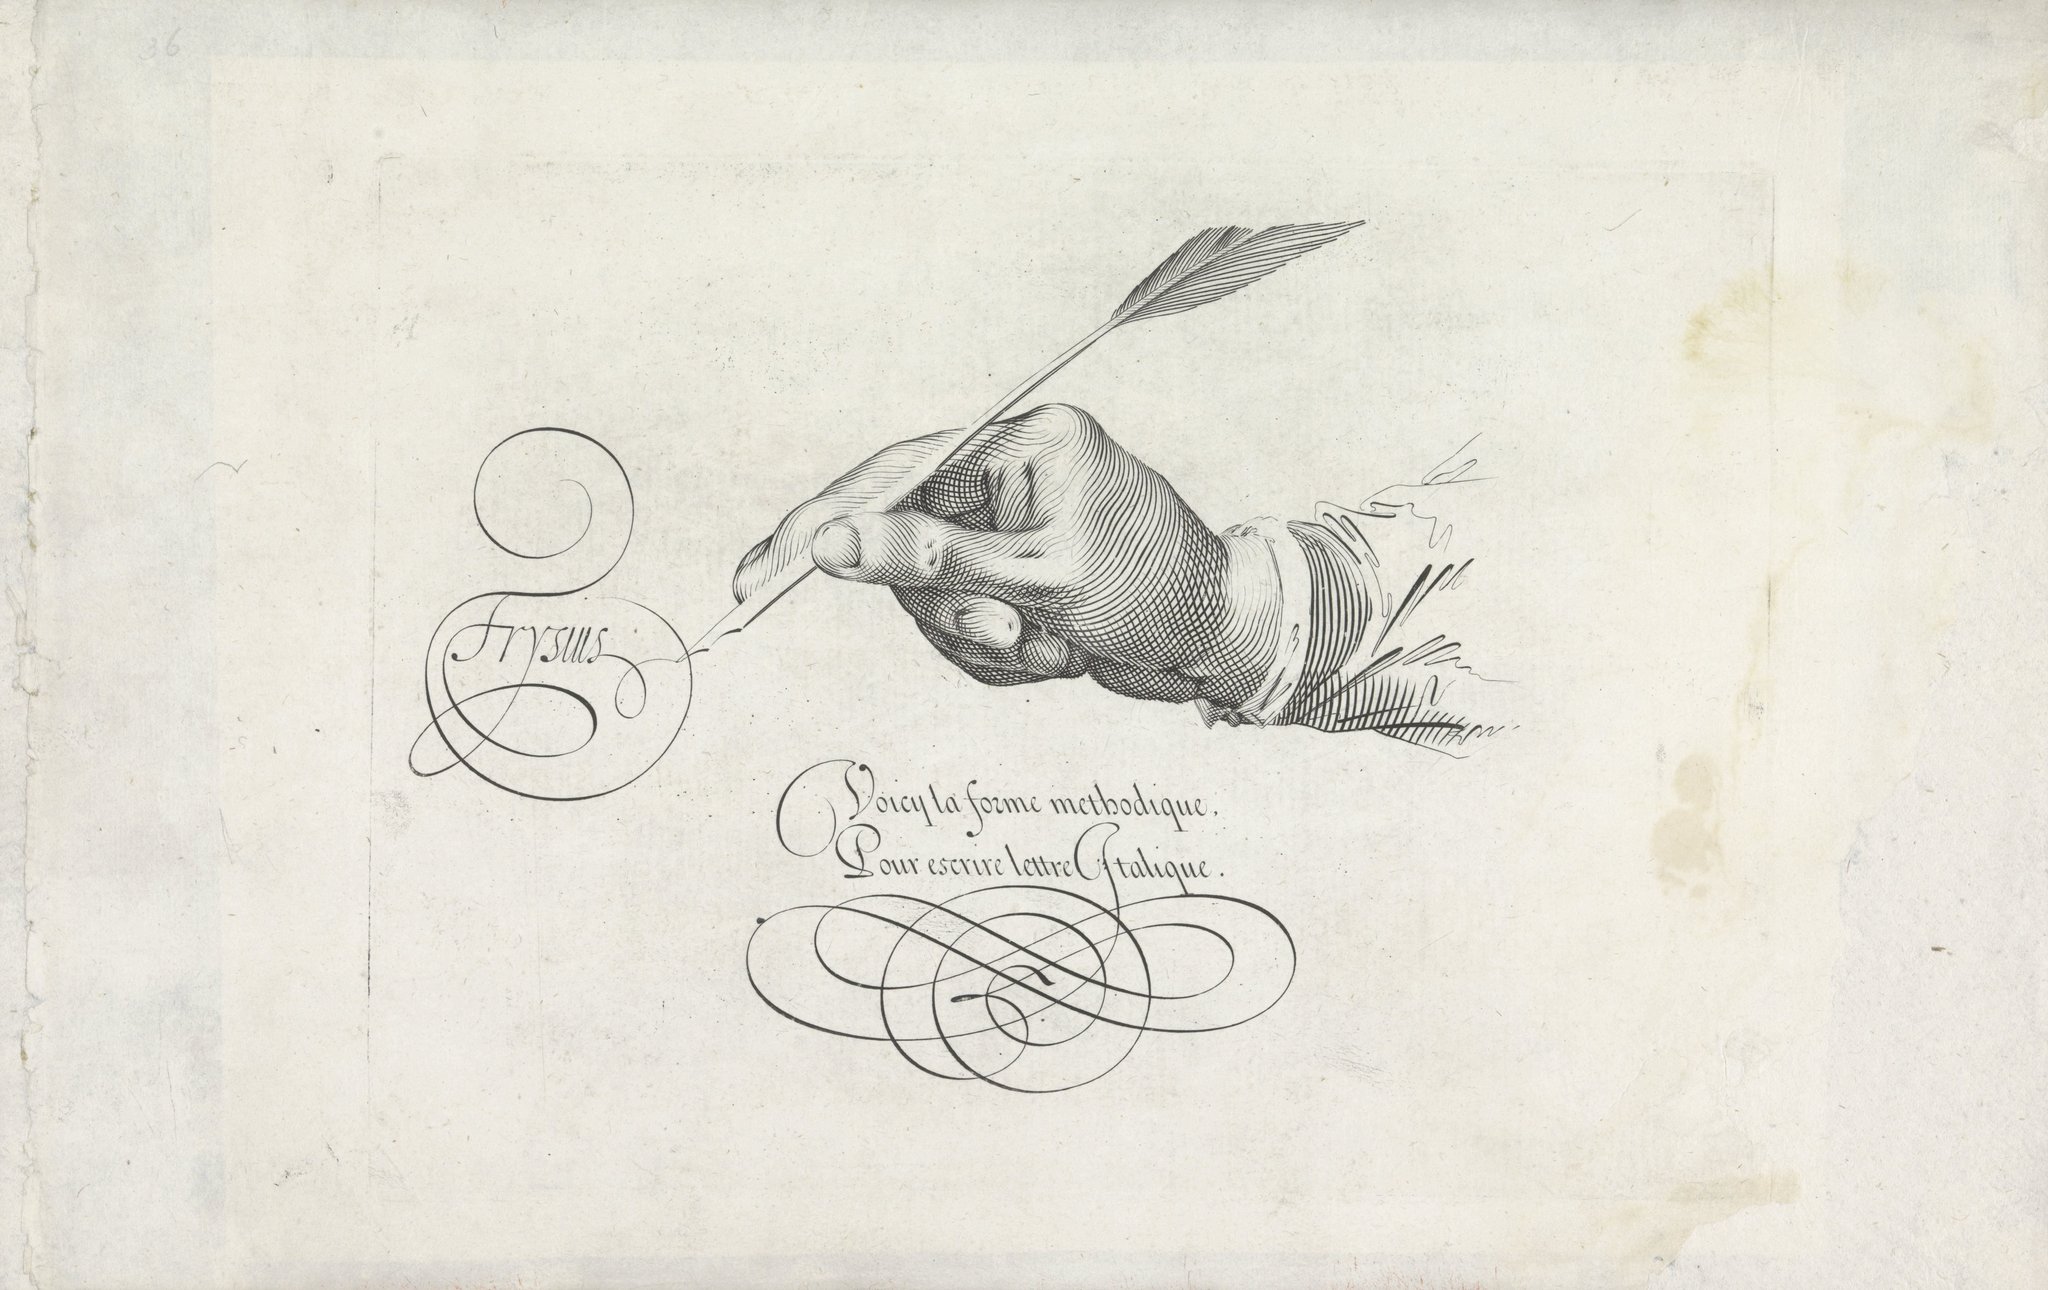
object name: album leaf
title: Spieghel der schrijfkonste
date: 1605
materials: paper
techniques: engraving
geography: haarlem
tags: handwriting, writing as activity, quill, calligraphy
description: Rechterhand met ganzenpen, Frysius schrijvend. Met tweeregelig onderschrift in het Frans: Voicy la forme methodique ... De prent maakt deel uit van een album.